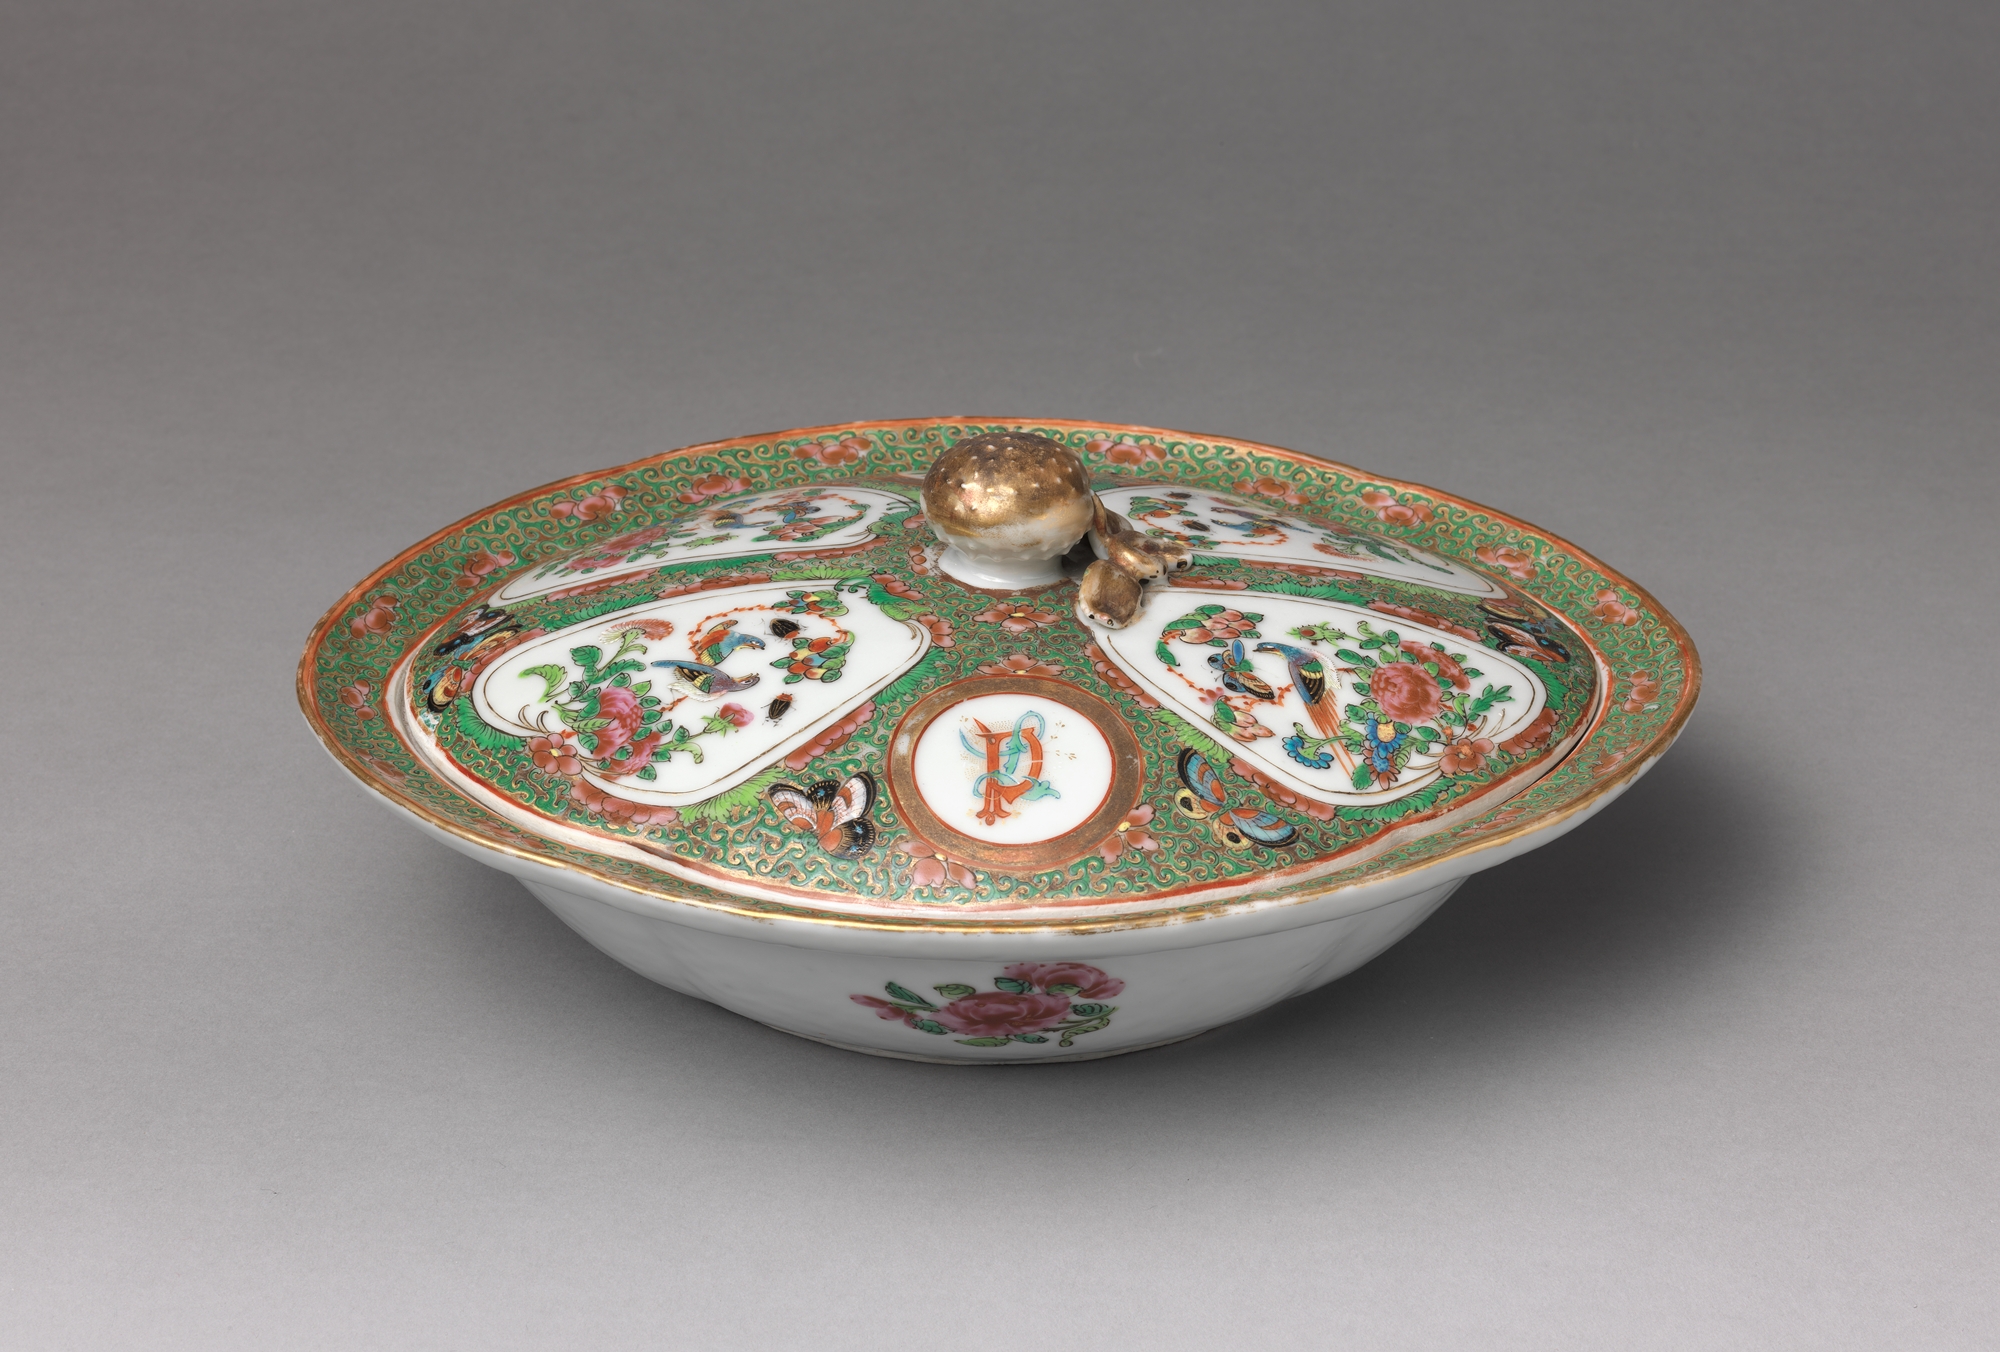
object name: serving dish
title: Covered Serving Dish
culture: chinese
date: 1860-1866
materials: porcelain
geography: china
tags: birds,butterflies,flowers